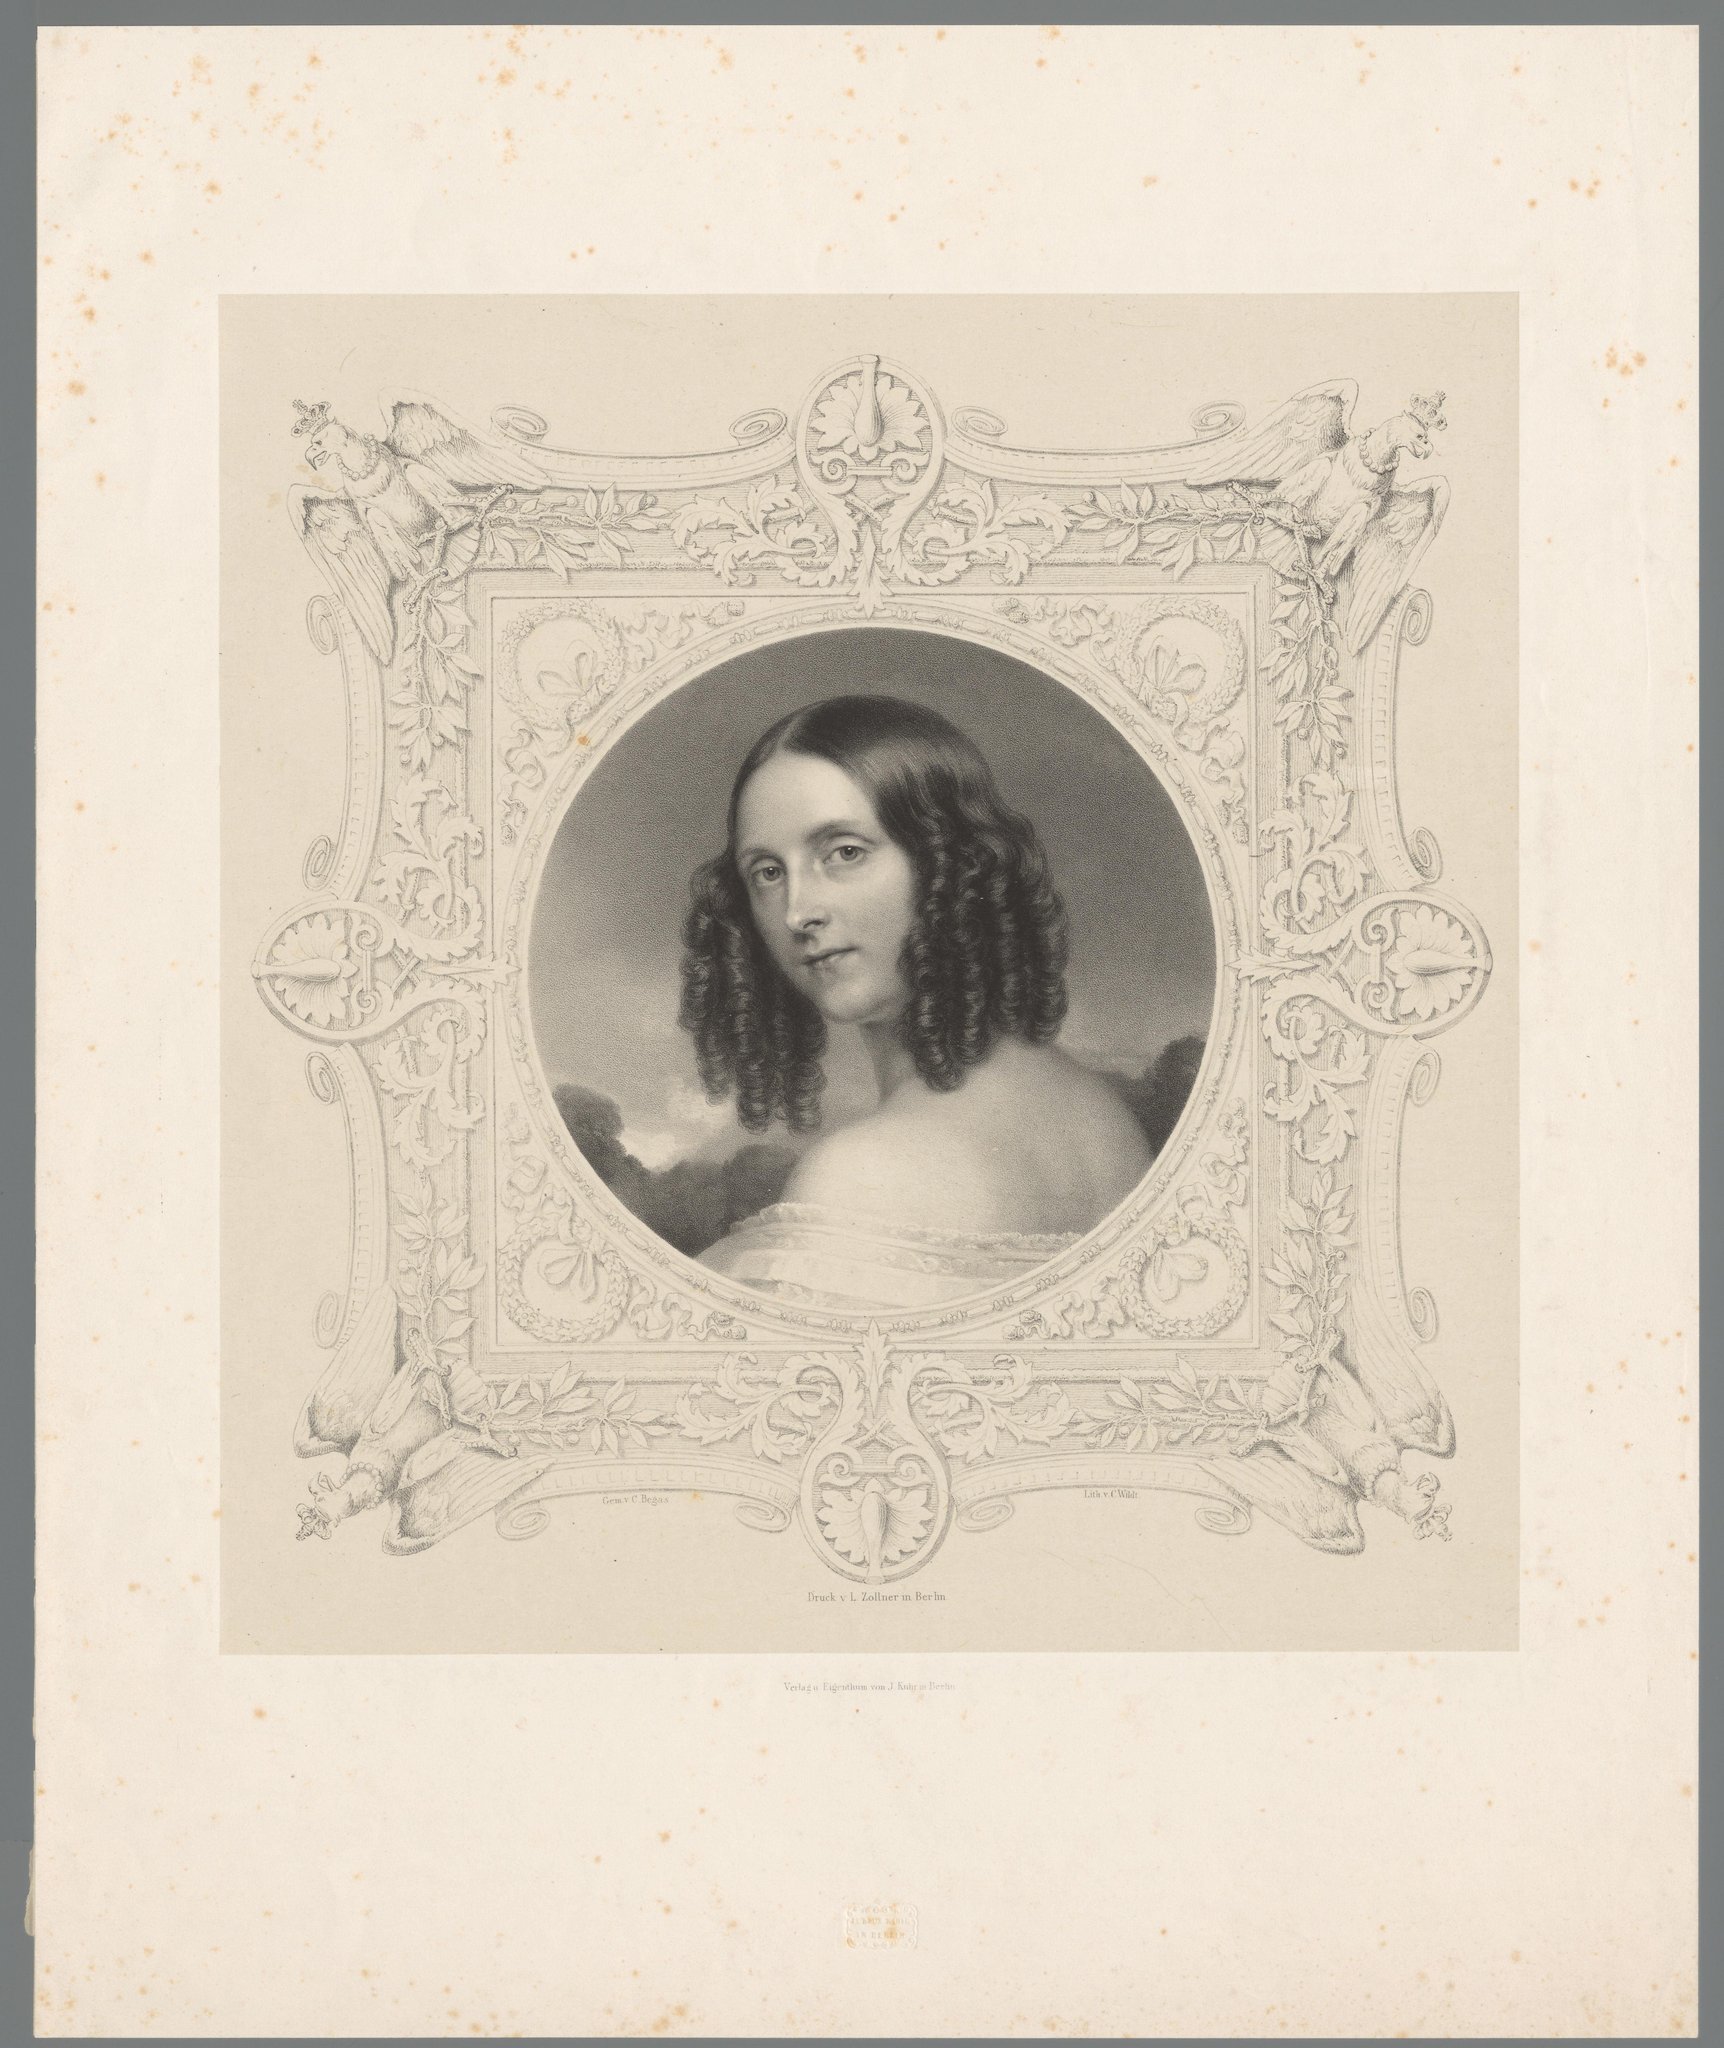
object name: print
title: Portret van Marie, prinses van Pruisen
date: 1830-1860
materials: paper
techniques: lithograph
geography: berlin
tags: berlin, adult woman, historical persons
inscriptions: collector's mark: Lugt 2228, collector's mark: Lugt 2760, check stamp: ‘Julius Kuhr in Berlin’